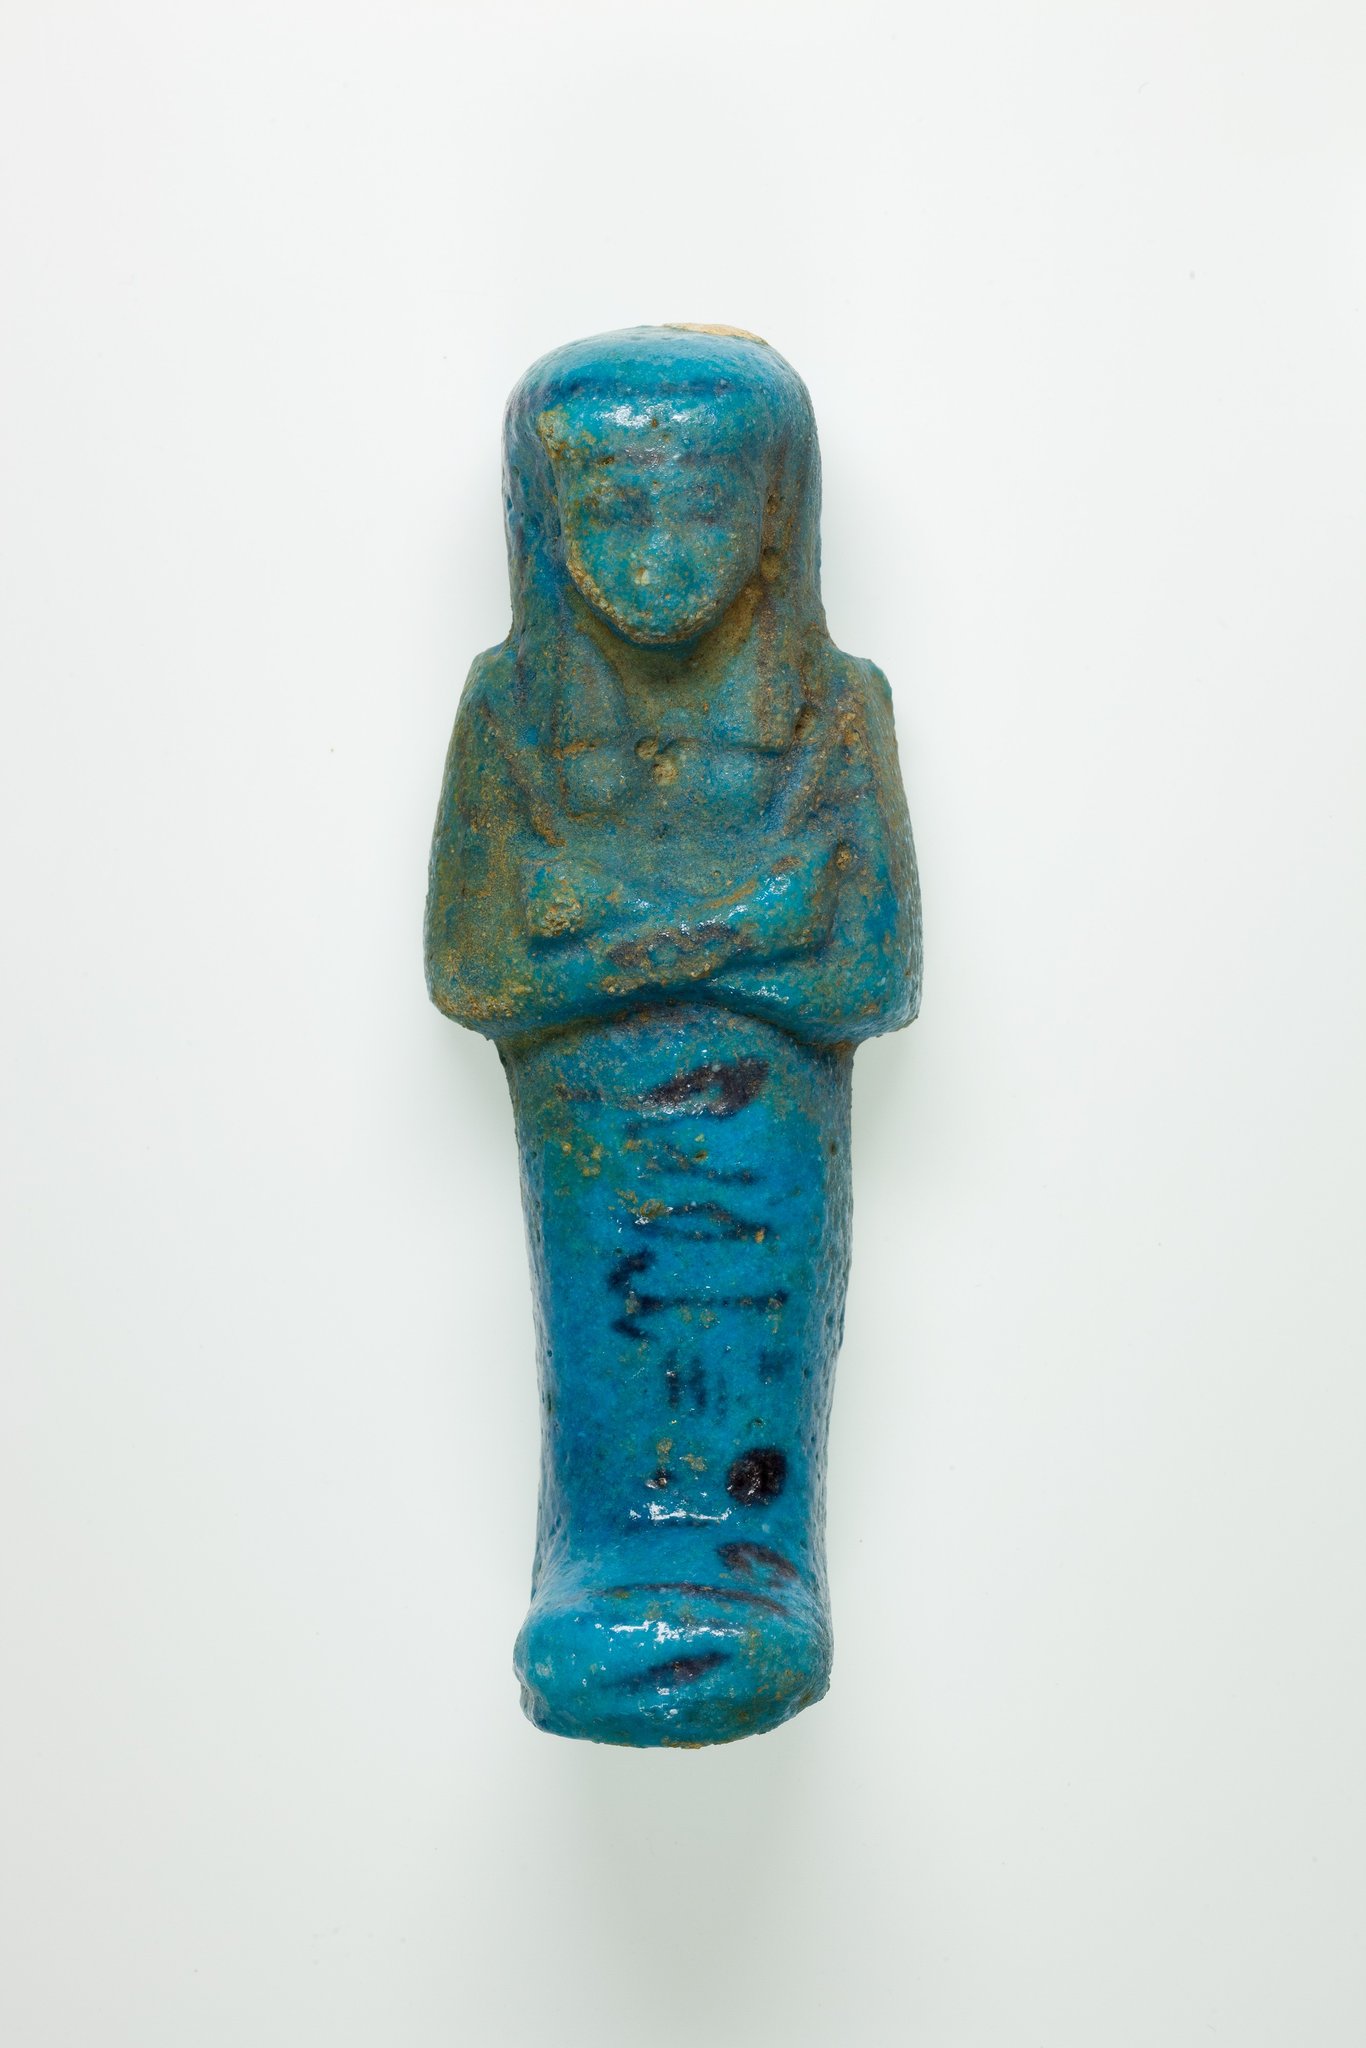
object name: worker shabti, henettawy c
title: Worker Shabti of Henettawy (C), Daughter of Isetemkheb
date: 990-970 BCE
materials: faience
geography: egypt